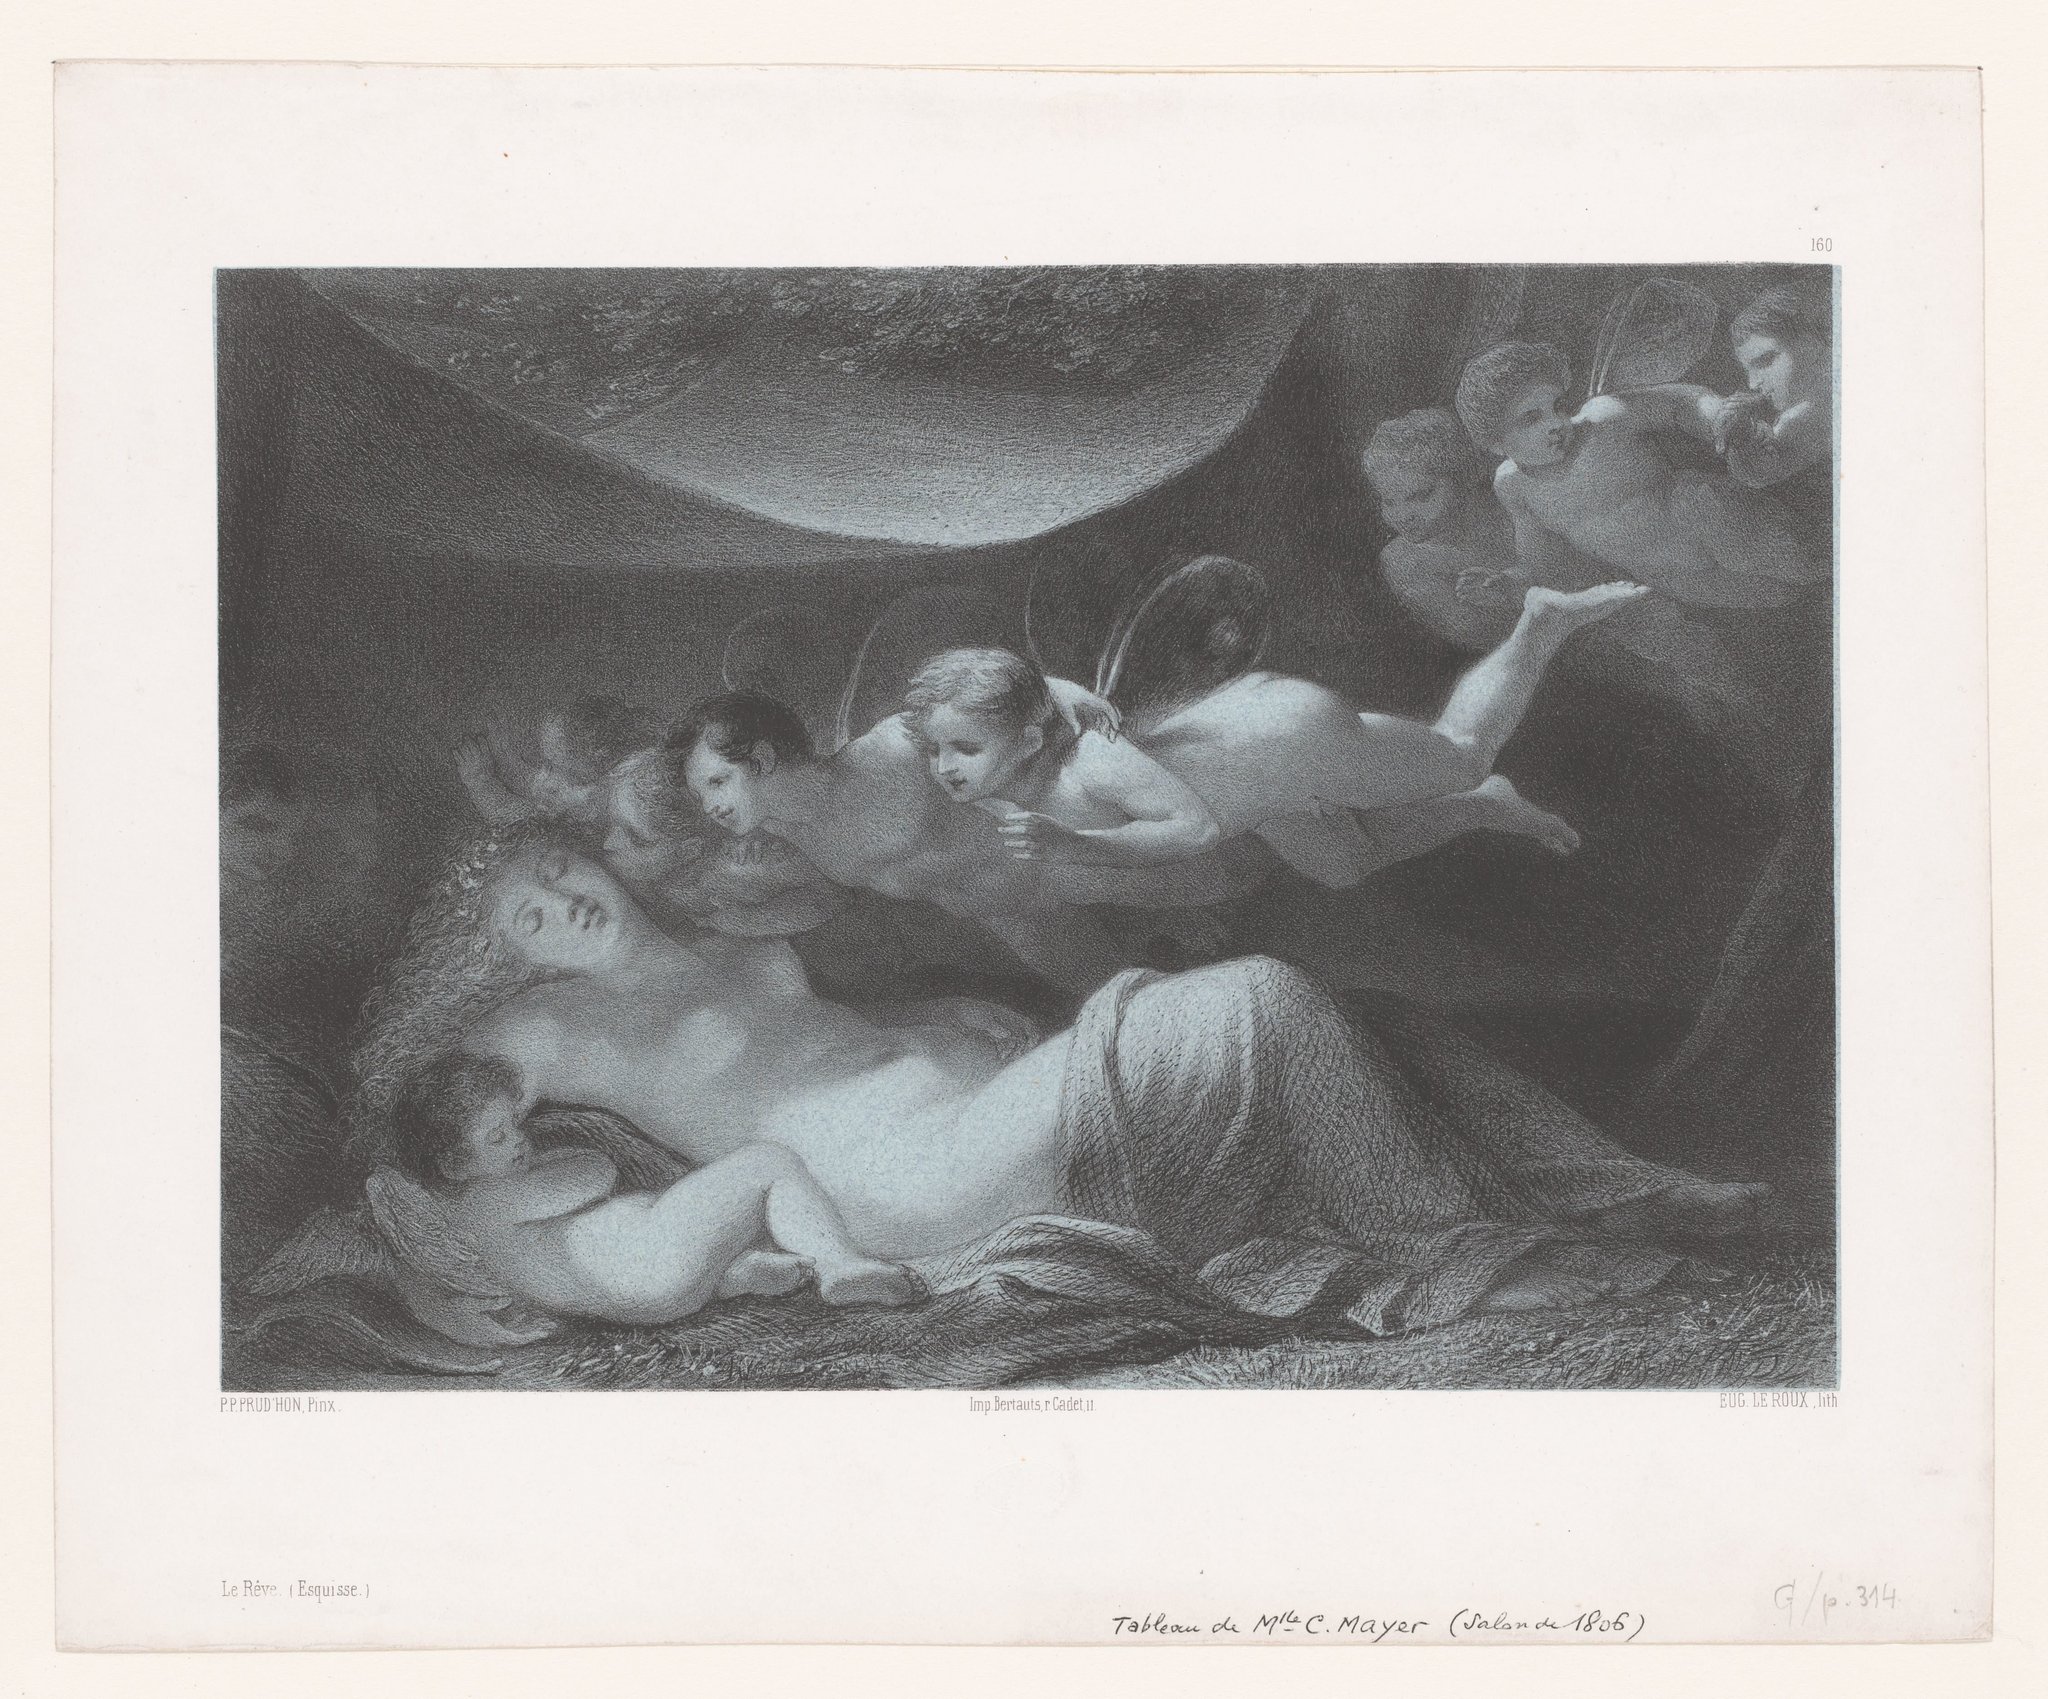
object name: print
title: Le Rêve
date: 1846-1853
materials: paper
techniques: lithograph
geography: paris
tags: psyche, on her way back, opens proserpina's casket and is overcome by sleep, (story of) cupid, amor (eros), cupids: 'amores', 'amoretti', 'putti'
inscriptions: collector's mark: Lugt 2228, check stamp: Lugt 36a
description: Prent uit: Les artistes anciens et modernes, 1846-1853.